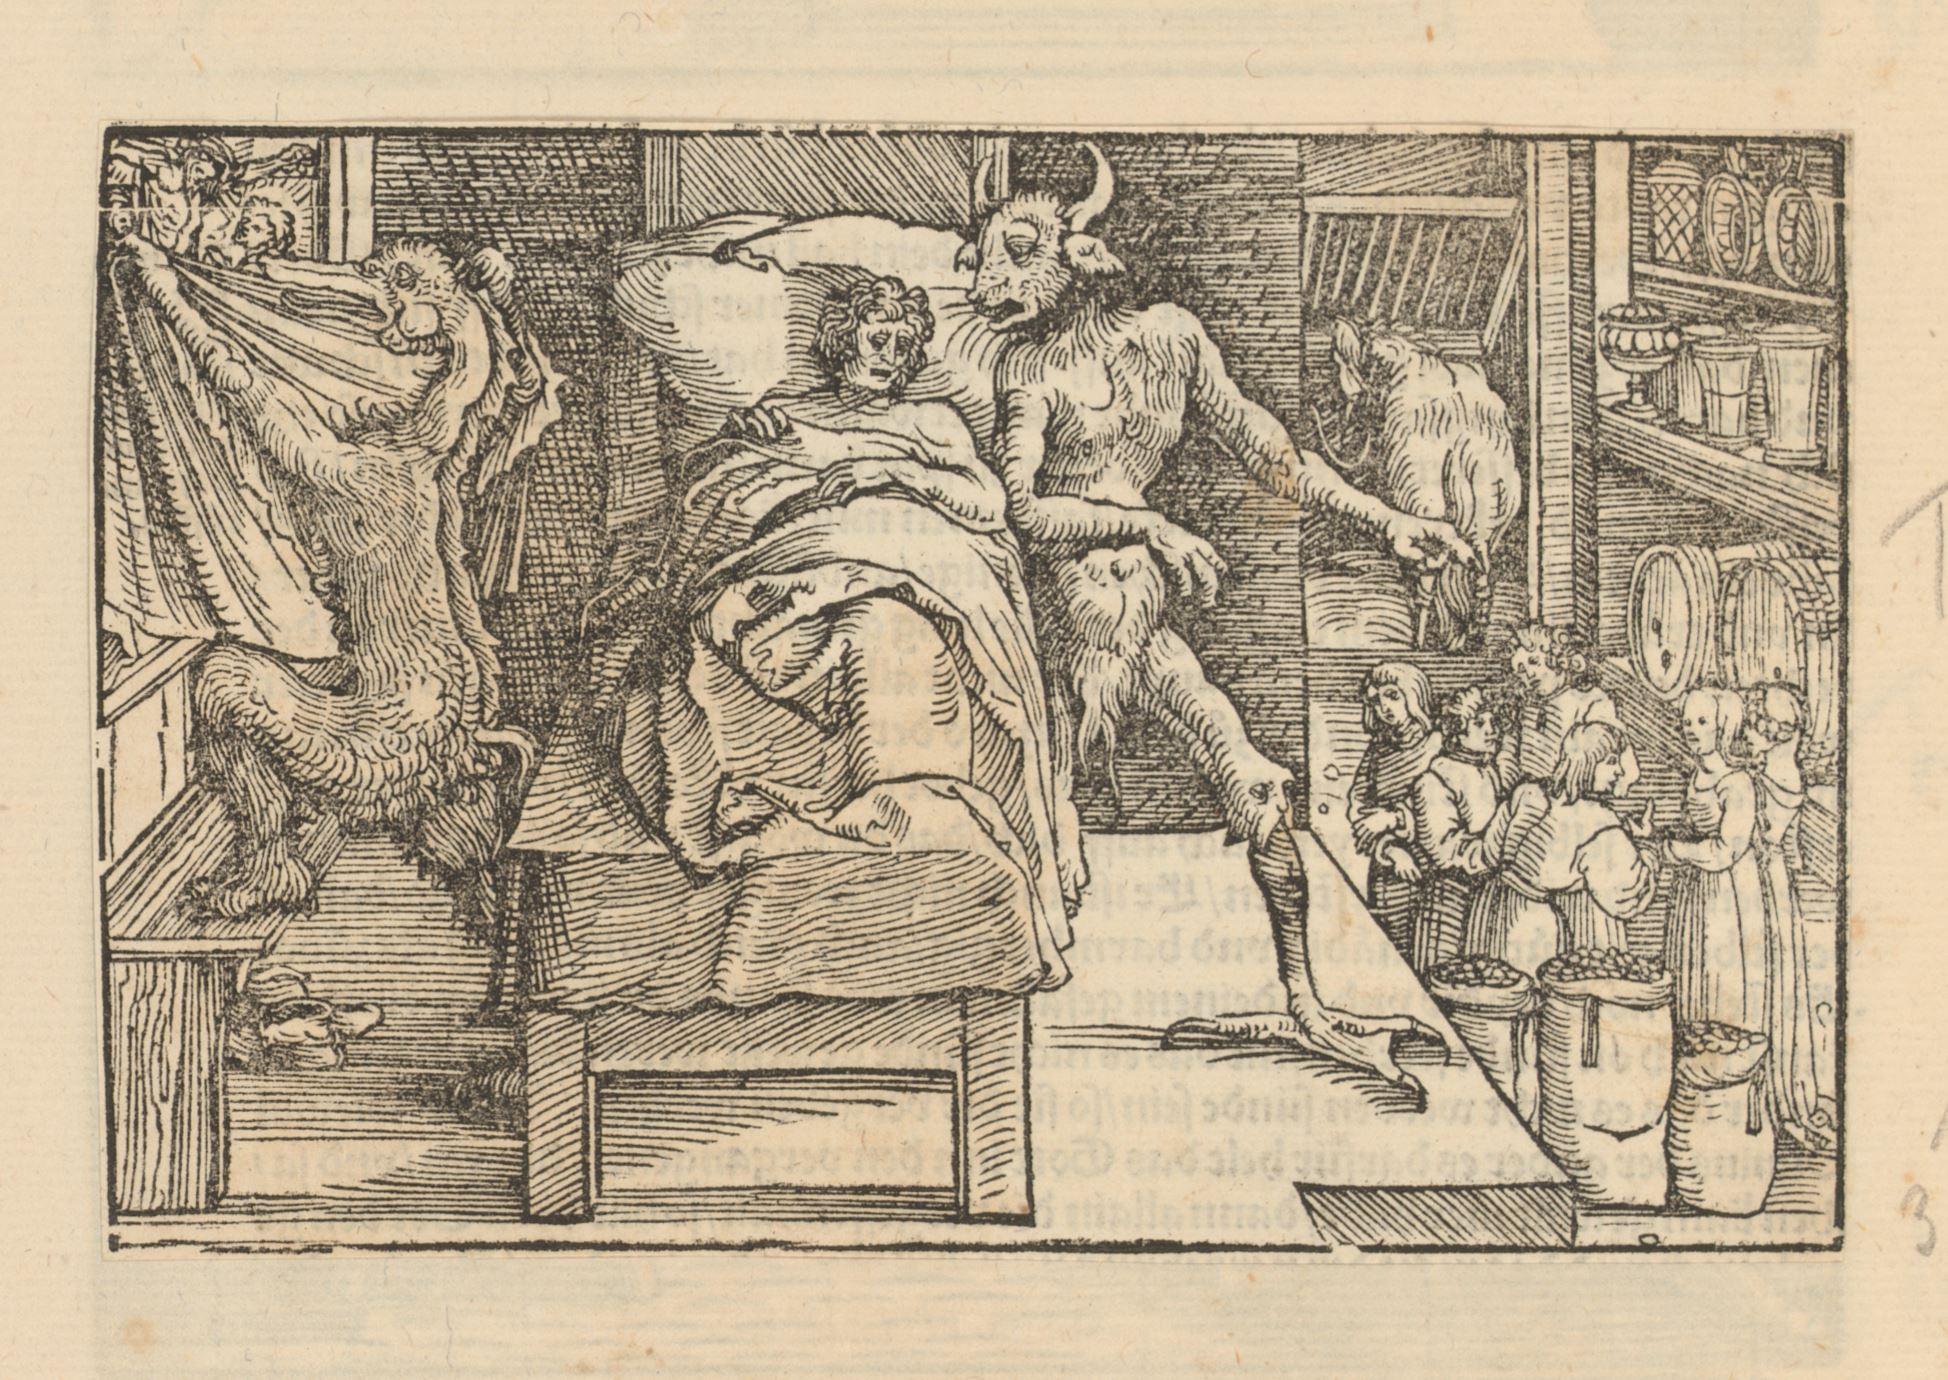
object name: album leaf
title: Demonen bij een sterfbed wijzen naar de erfenis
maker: Anonymous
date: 1514-1532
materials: paper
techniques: letterpress printing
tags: inheritance, devil(s) appearing to mortals, trying to seduce them; temptation, orphans, death struggle, inquiet death; fear of death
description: Deze prent is gebruikt in: Petrarca, Francesco. Von der Artzney bayder Glück, des guten und widerwertigen: unnd weß sich ain yeder inn Gelück und Unglück halten sol (...). Augsburg: Heinrich Steiner, 1532. Deze uitgave is ook bekend onder de titel 'Trostspiegel in Glück und Unglück'.